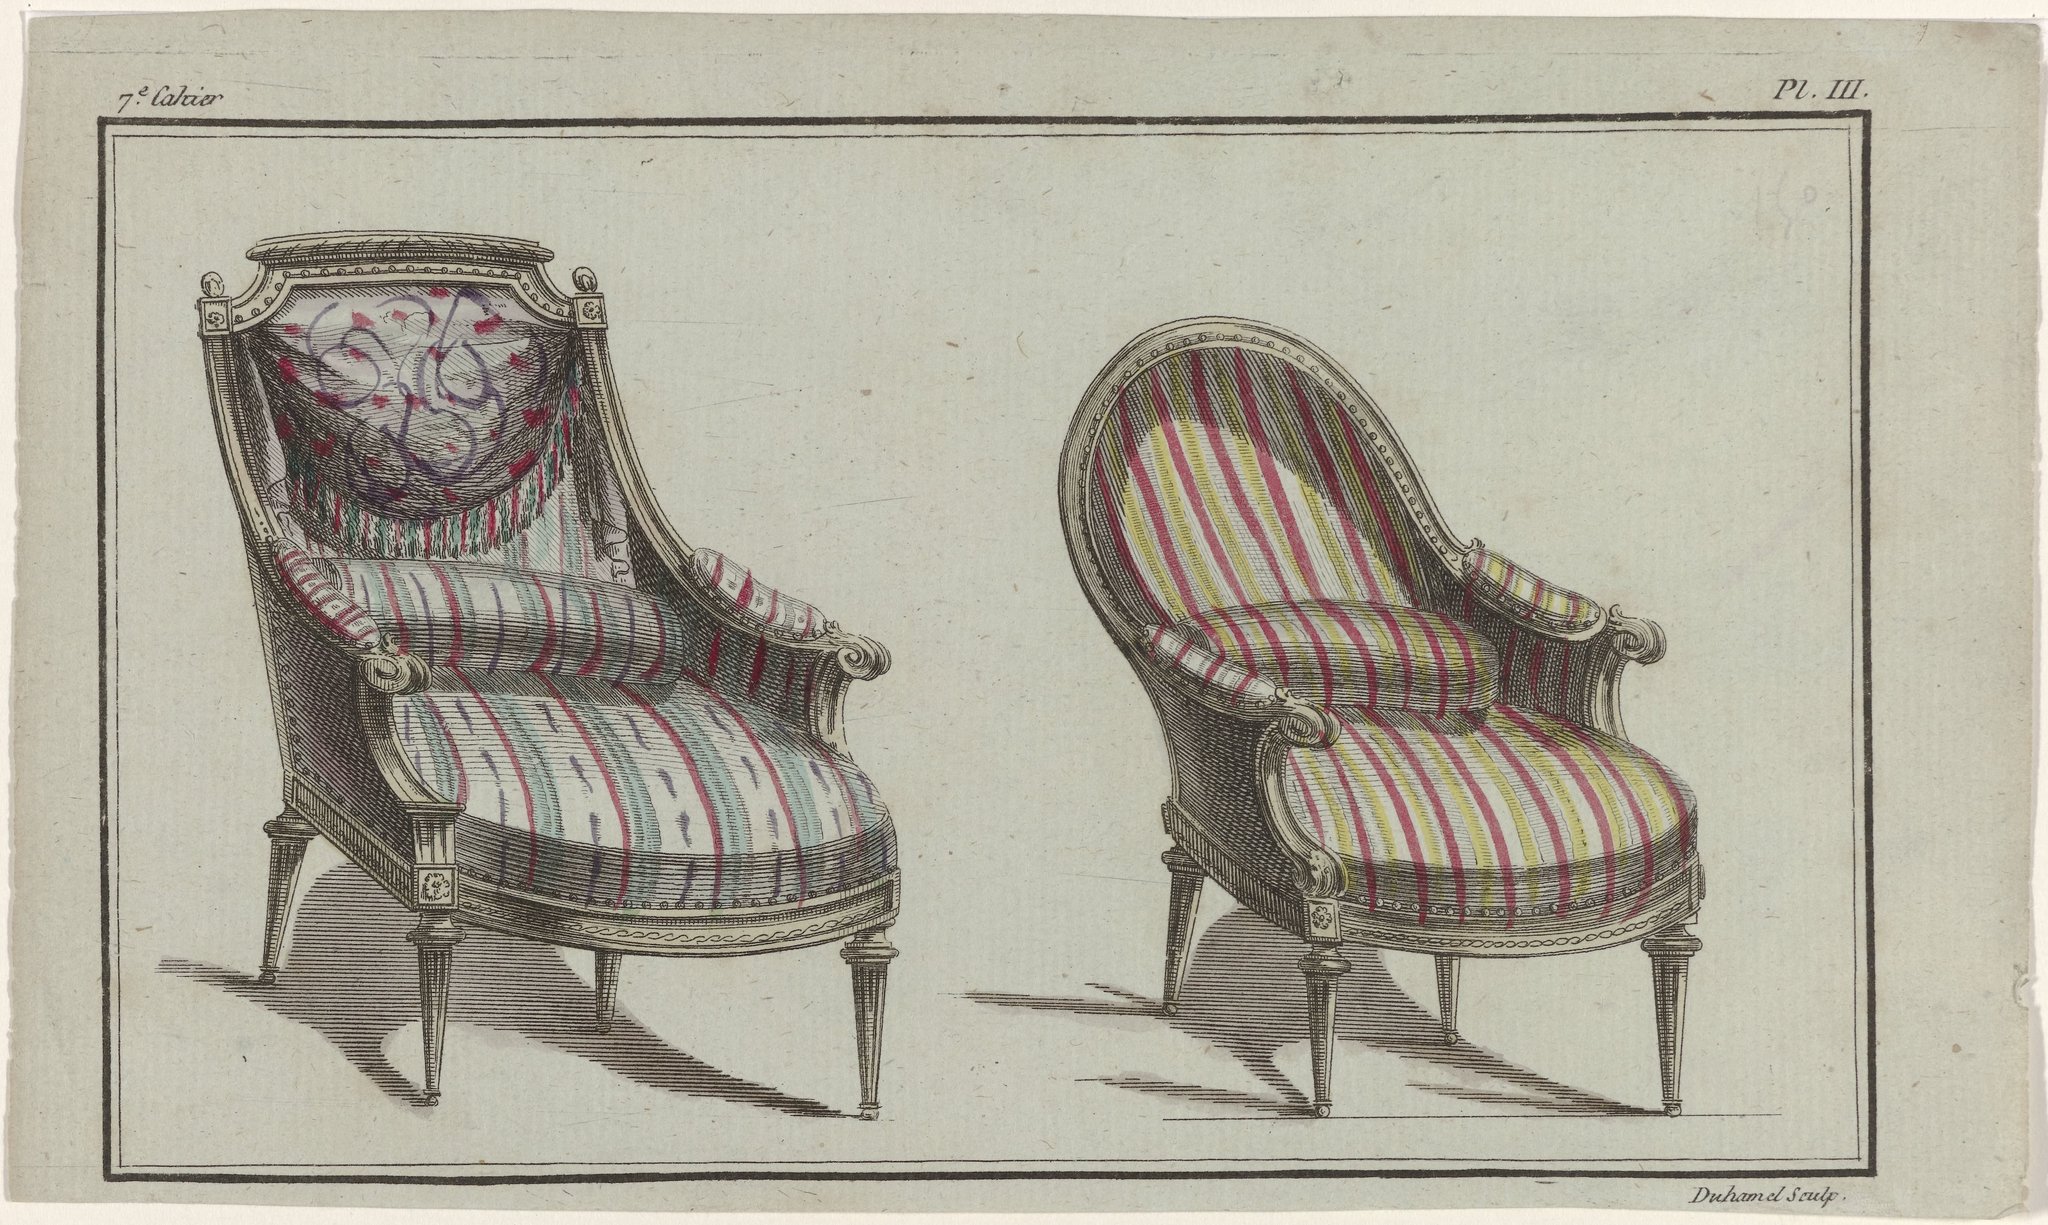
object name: fashion print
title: Fashion News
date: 1786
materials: paper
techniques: engraving, hand coloring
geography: paris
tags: fashion plates, chair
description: The Cabinet des Modes offered readers highly detailed information about the illustrated clothes and accessories. It reported, for instance, on new clothing styles, such as the English ‘redingote’ 1; on accessories and embellishments, such as oversized muffs, buttons, ribbons and clasps; and finally, on the latest interior furnishings. For its male audience there was the fitted jacket 2 and the popular Androsmane, a hat with an upturned brim 3.